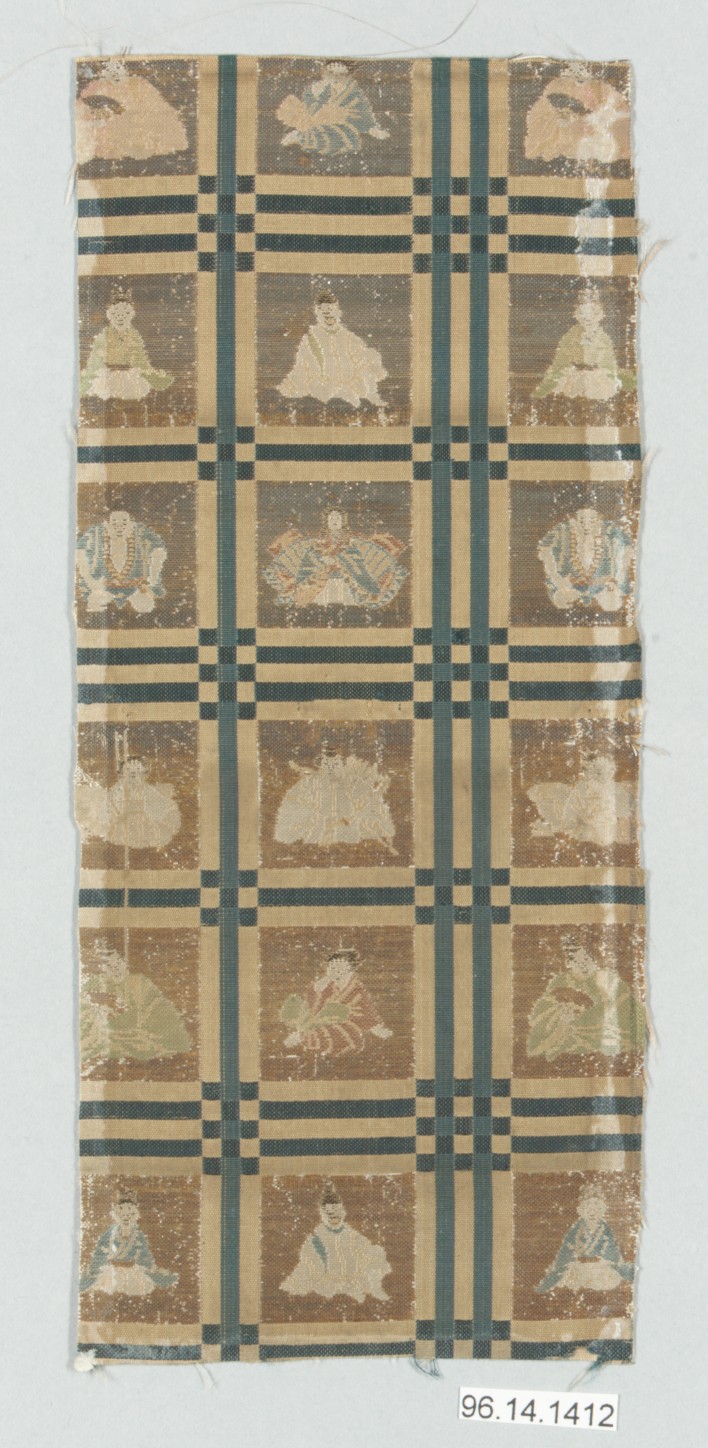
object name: piece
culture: japanese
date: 1767-1800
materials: metal thread, silk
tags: men,women